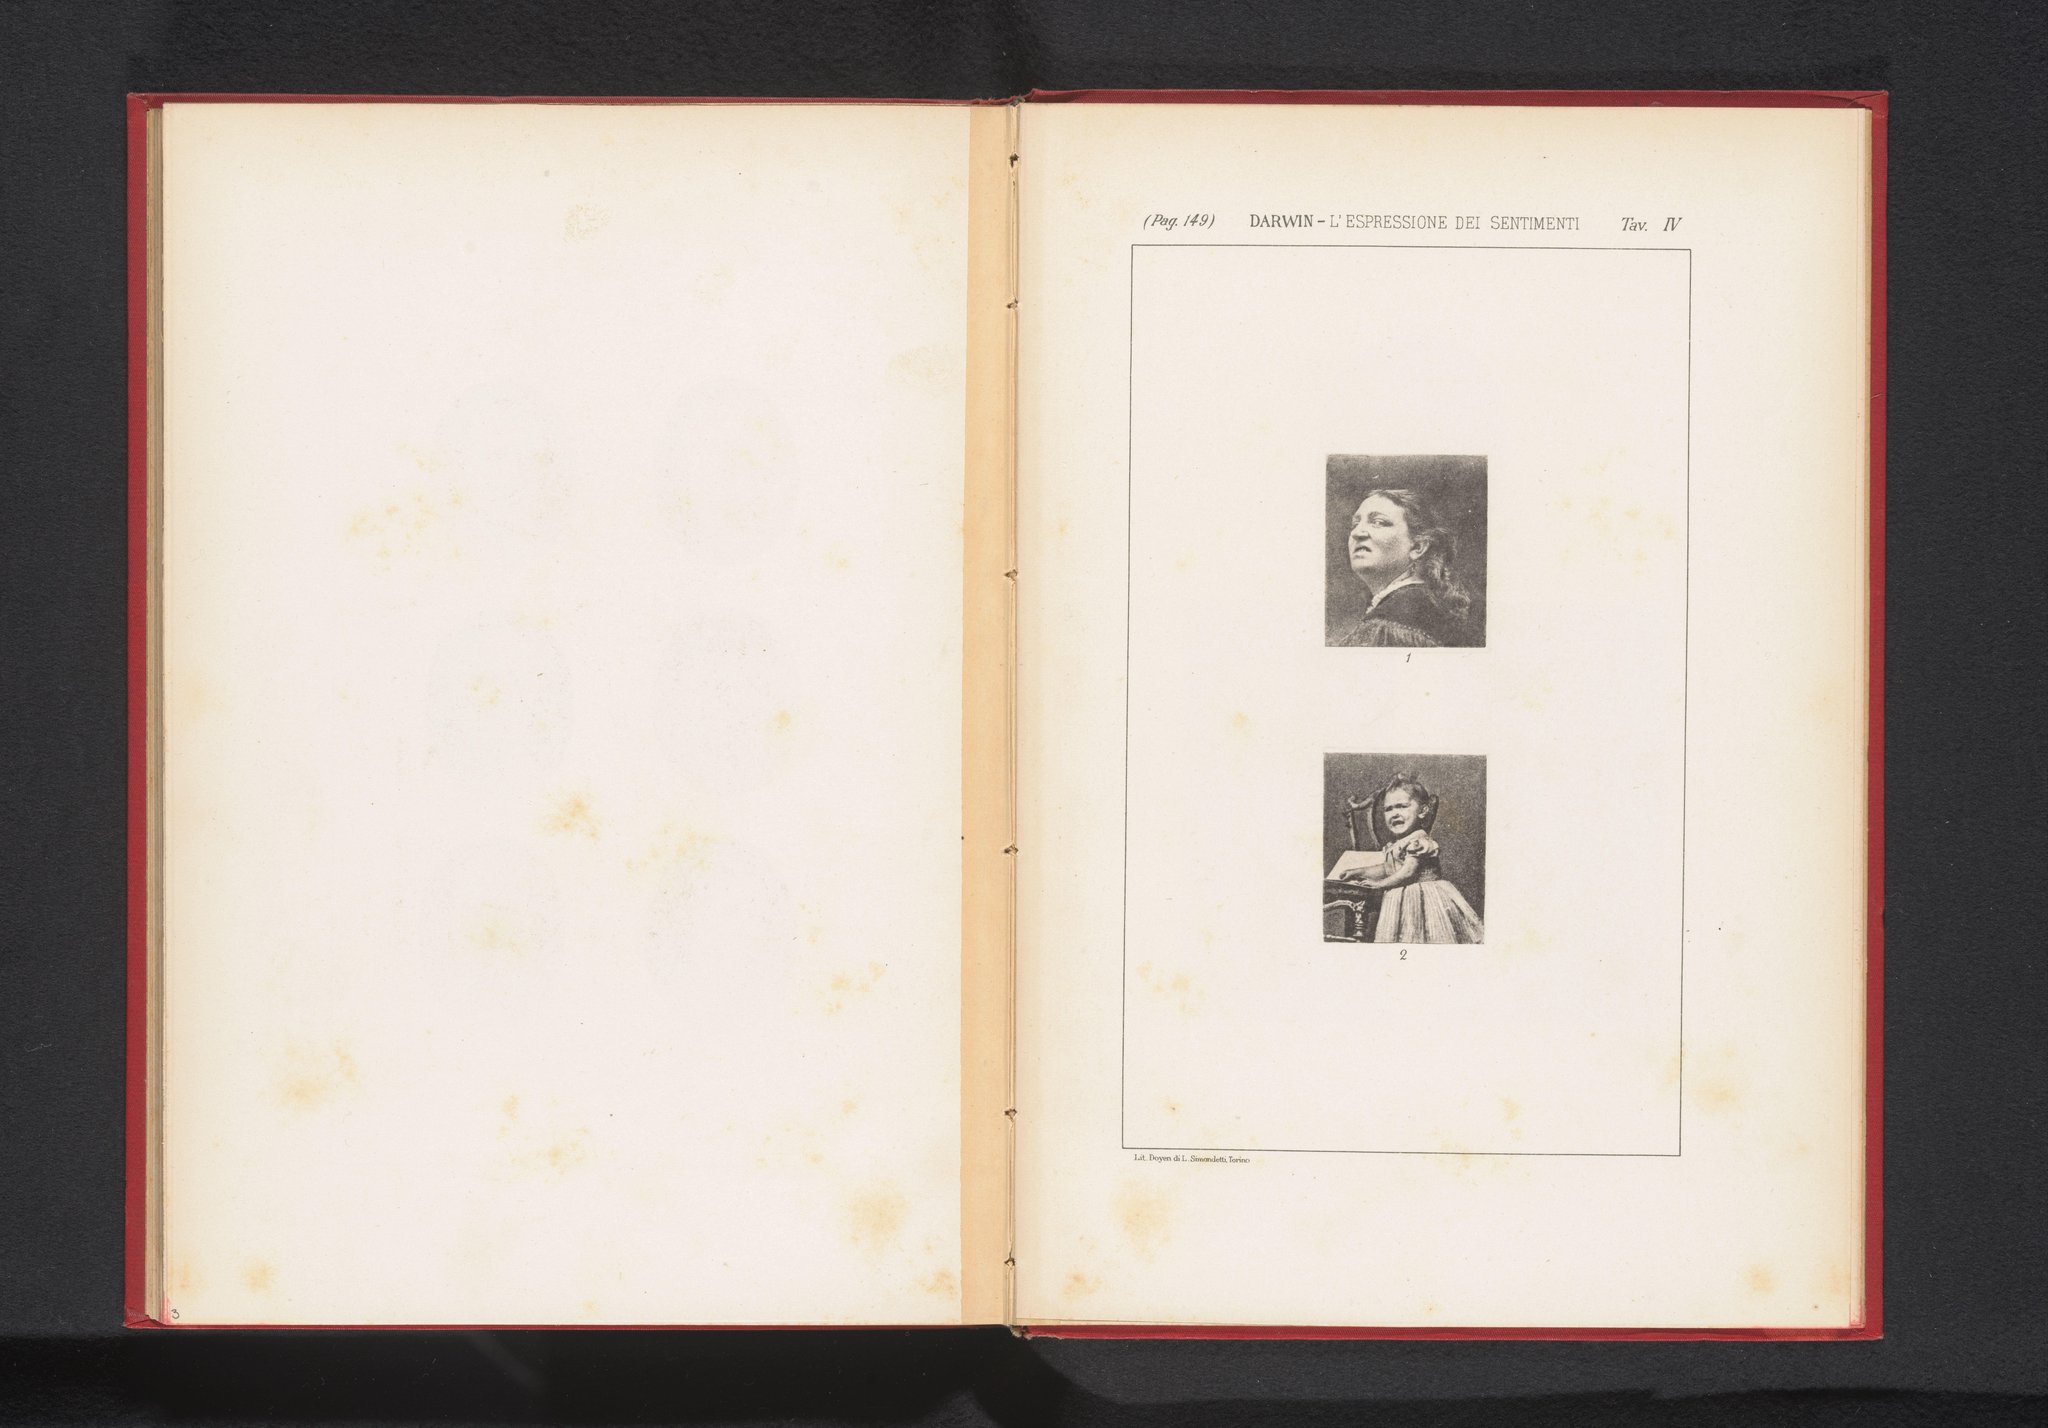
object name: photomechanical print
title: Twee portretten van een onbekende vrouw en een kind die woede en spot tonen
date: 1880-1890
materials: paper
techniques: photograph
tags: passions, emotions, affections, weeping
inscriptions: number: ‘Tav. IV 1 2 (Pag. 149)’